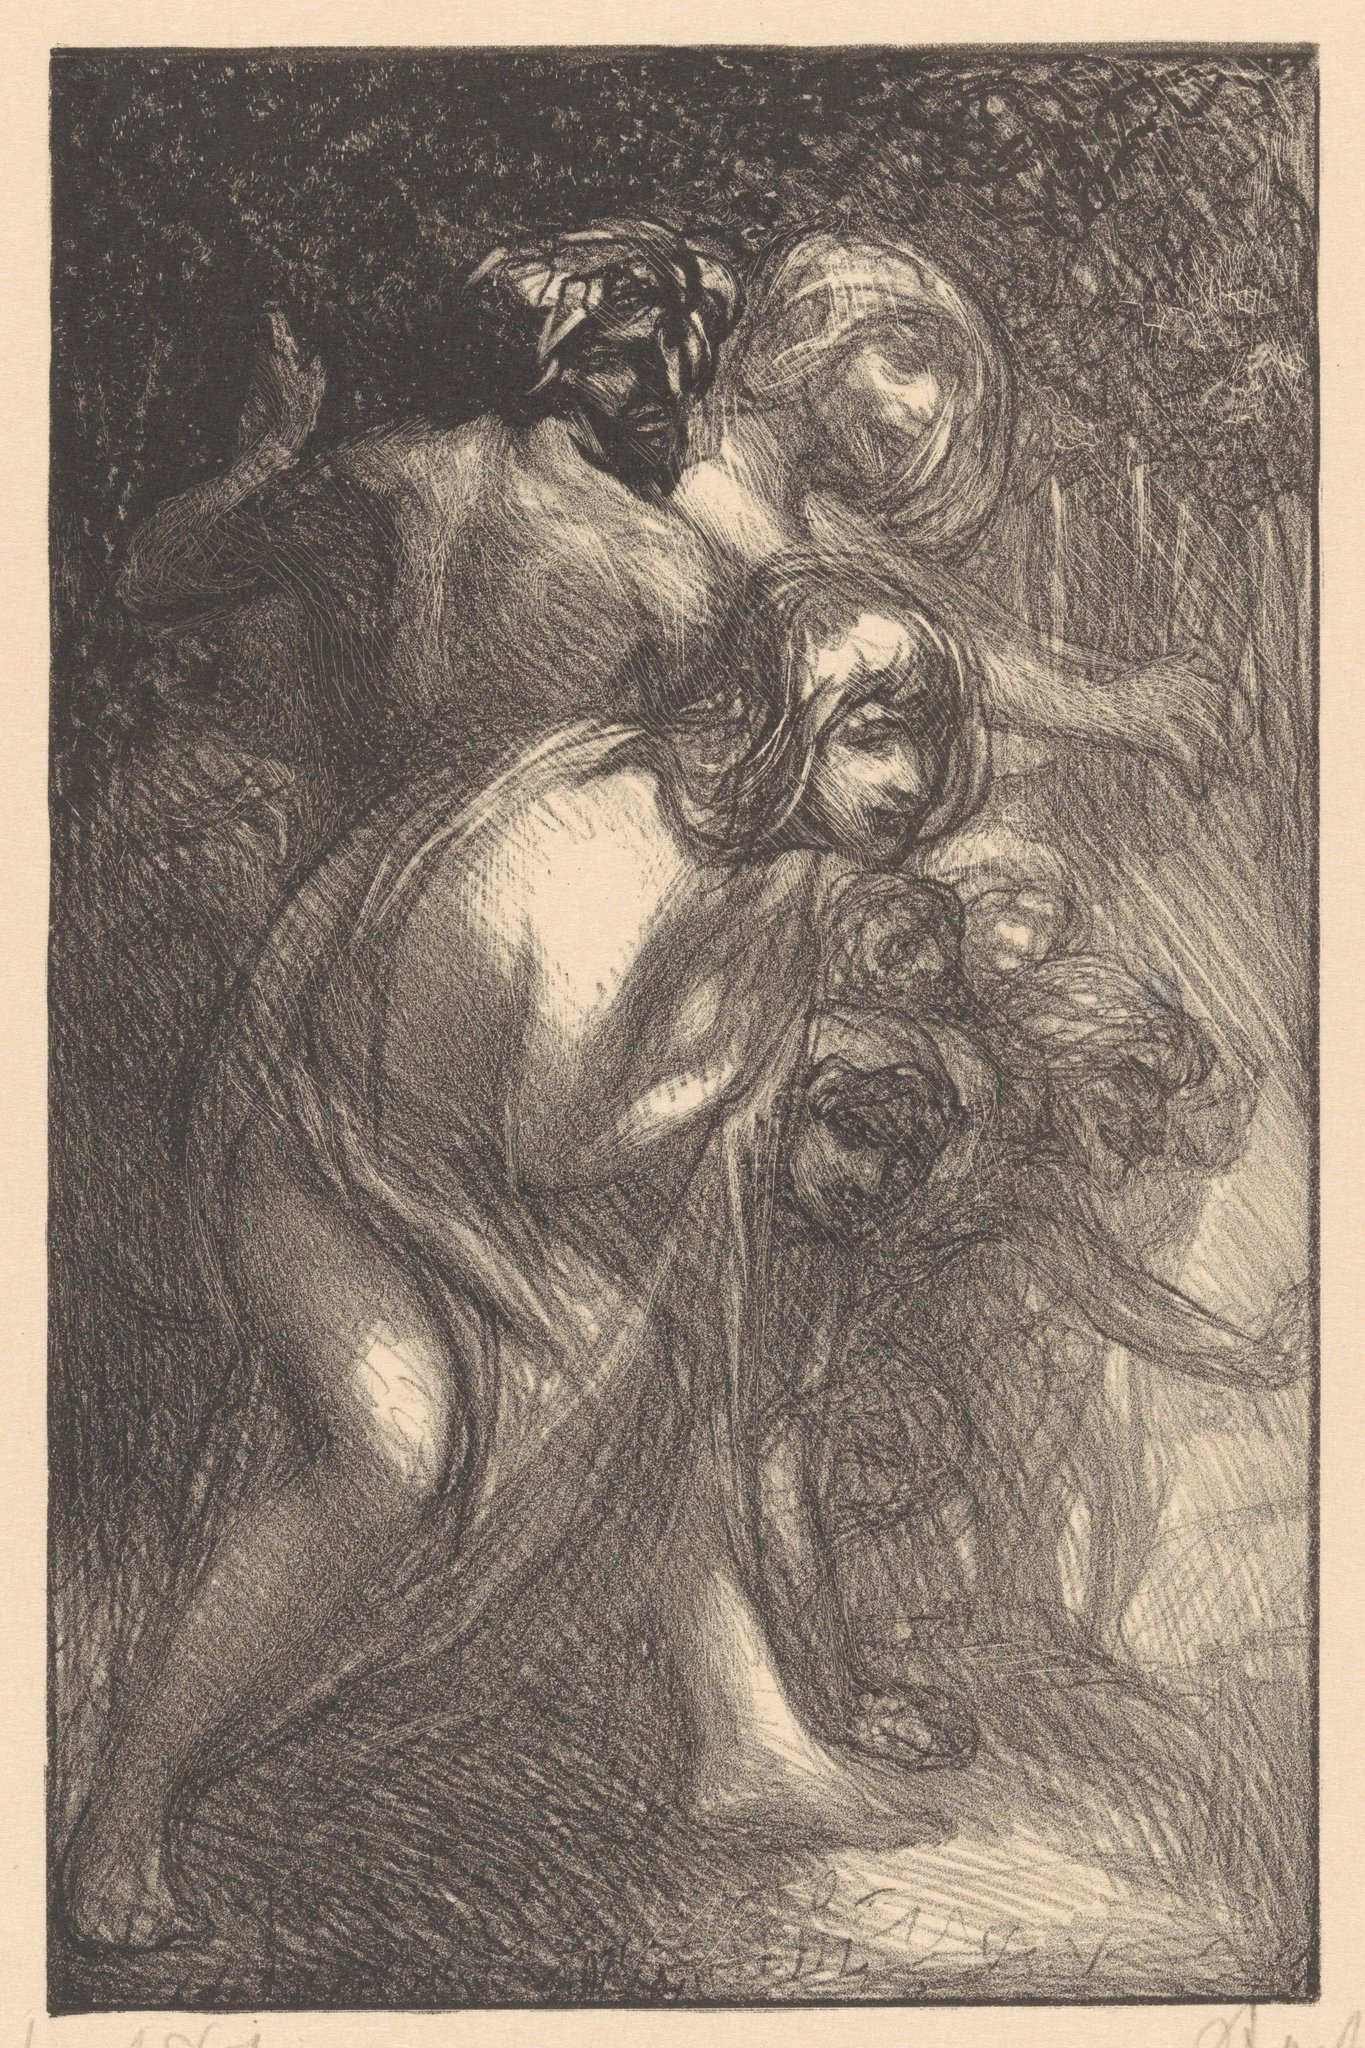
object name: print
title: Nimfen en een sater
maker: johannes josephus aarts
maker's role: draughtsman, print maker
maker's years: 1871-1934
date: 1927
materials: paper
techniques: lithograph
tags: partially clothed - aa - female human figure, nymphs (in general); 'ninfe in commune' (ripa), satyr(s) (in general)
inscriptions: collector's mark: Lugt 2228, collector's mark: Lugt 2760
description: Een groep staande en hurkende vrouwen, hoogstwaarschijnlijk nimfen. In hun midden een sater. Op de achtergrond gebladerte.